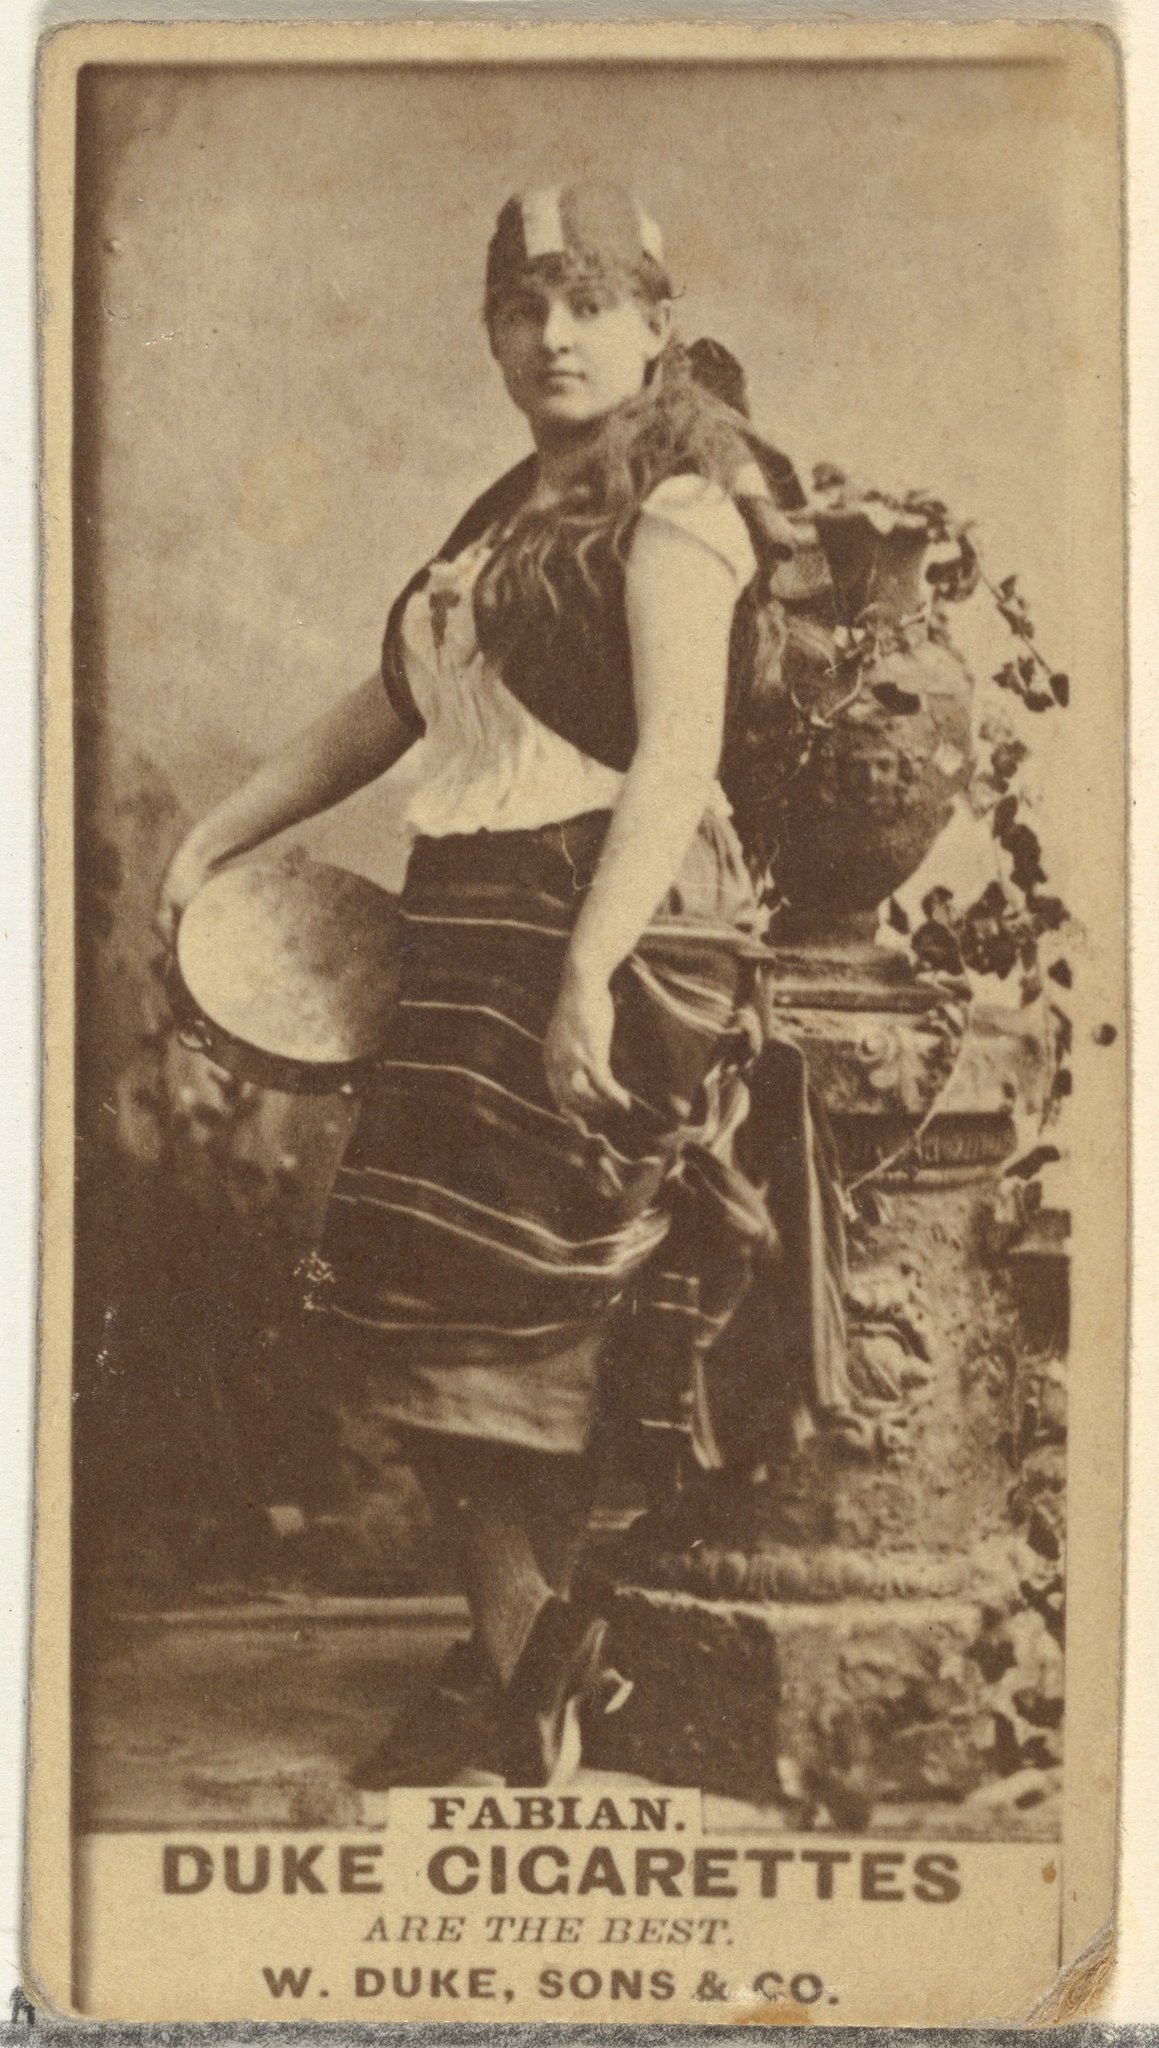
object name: photograph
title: Miss Fabian, from the Actors and Actresses series (N145-7) issued by Duke Sons & Co. to promote Duke Cigarettes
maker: w. duke, sons & co.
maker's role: publisher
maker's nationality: american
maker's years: 1870-1920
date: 1880-1889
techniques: albumen silver print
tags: portraits,women,actresses